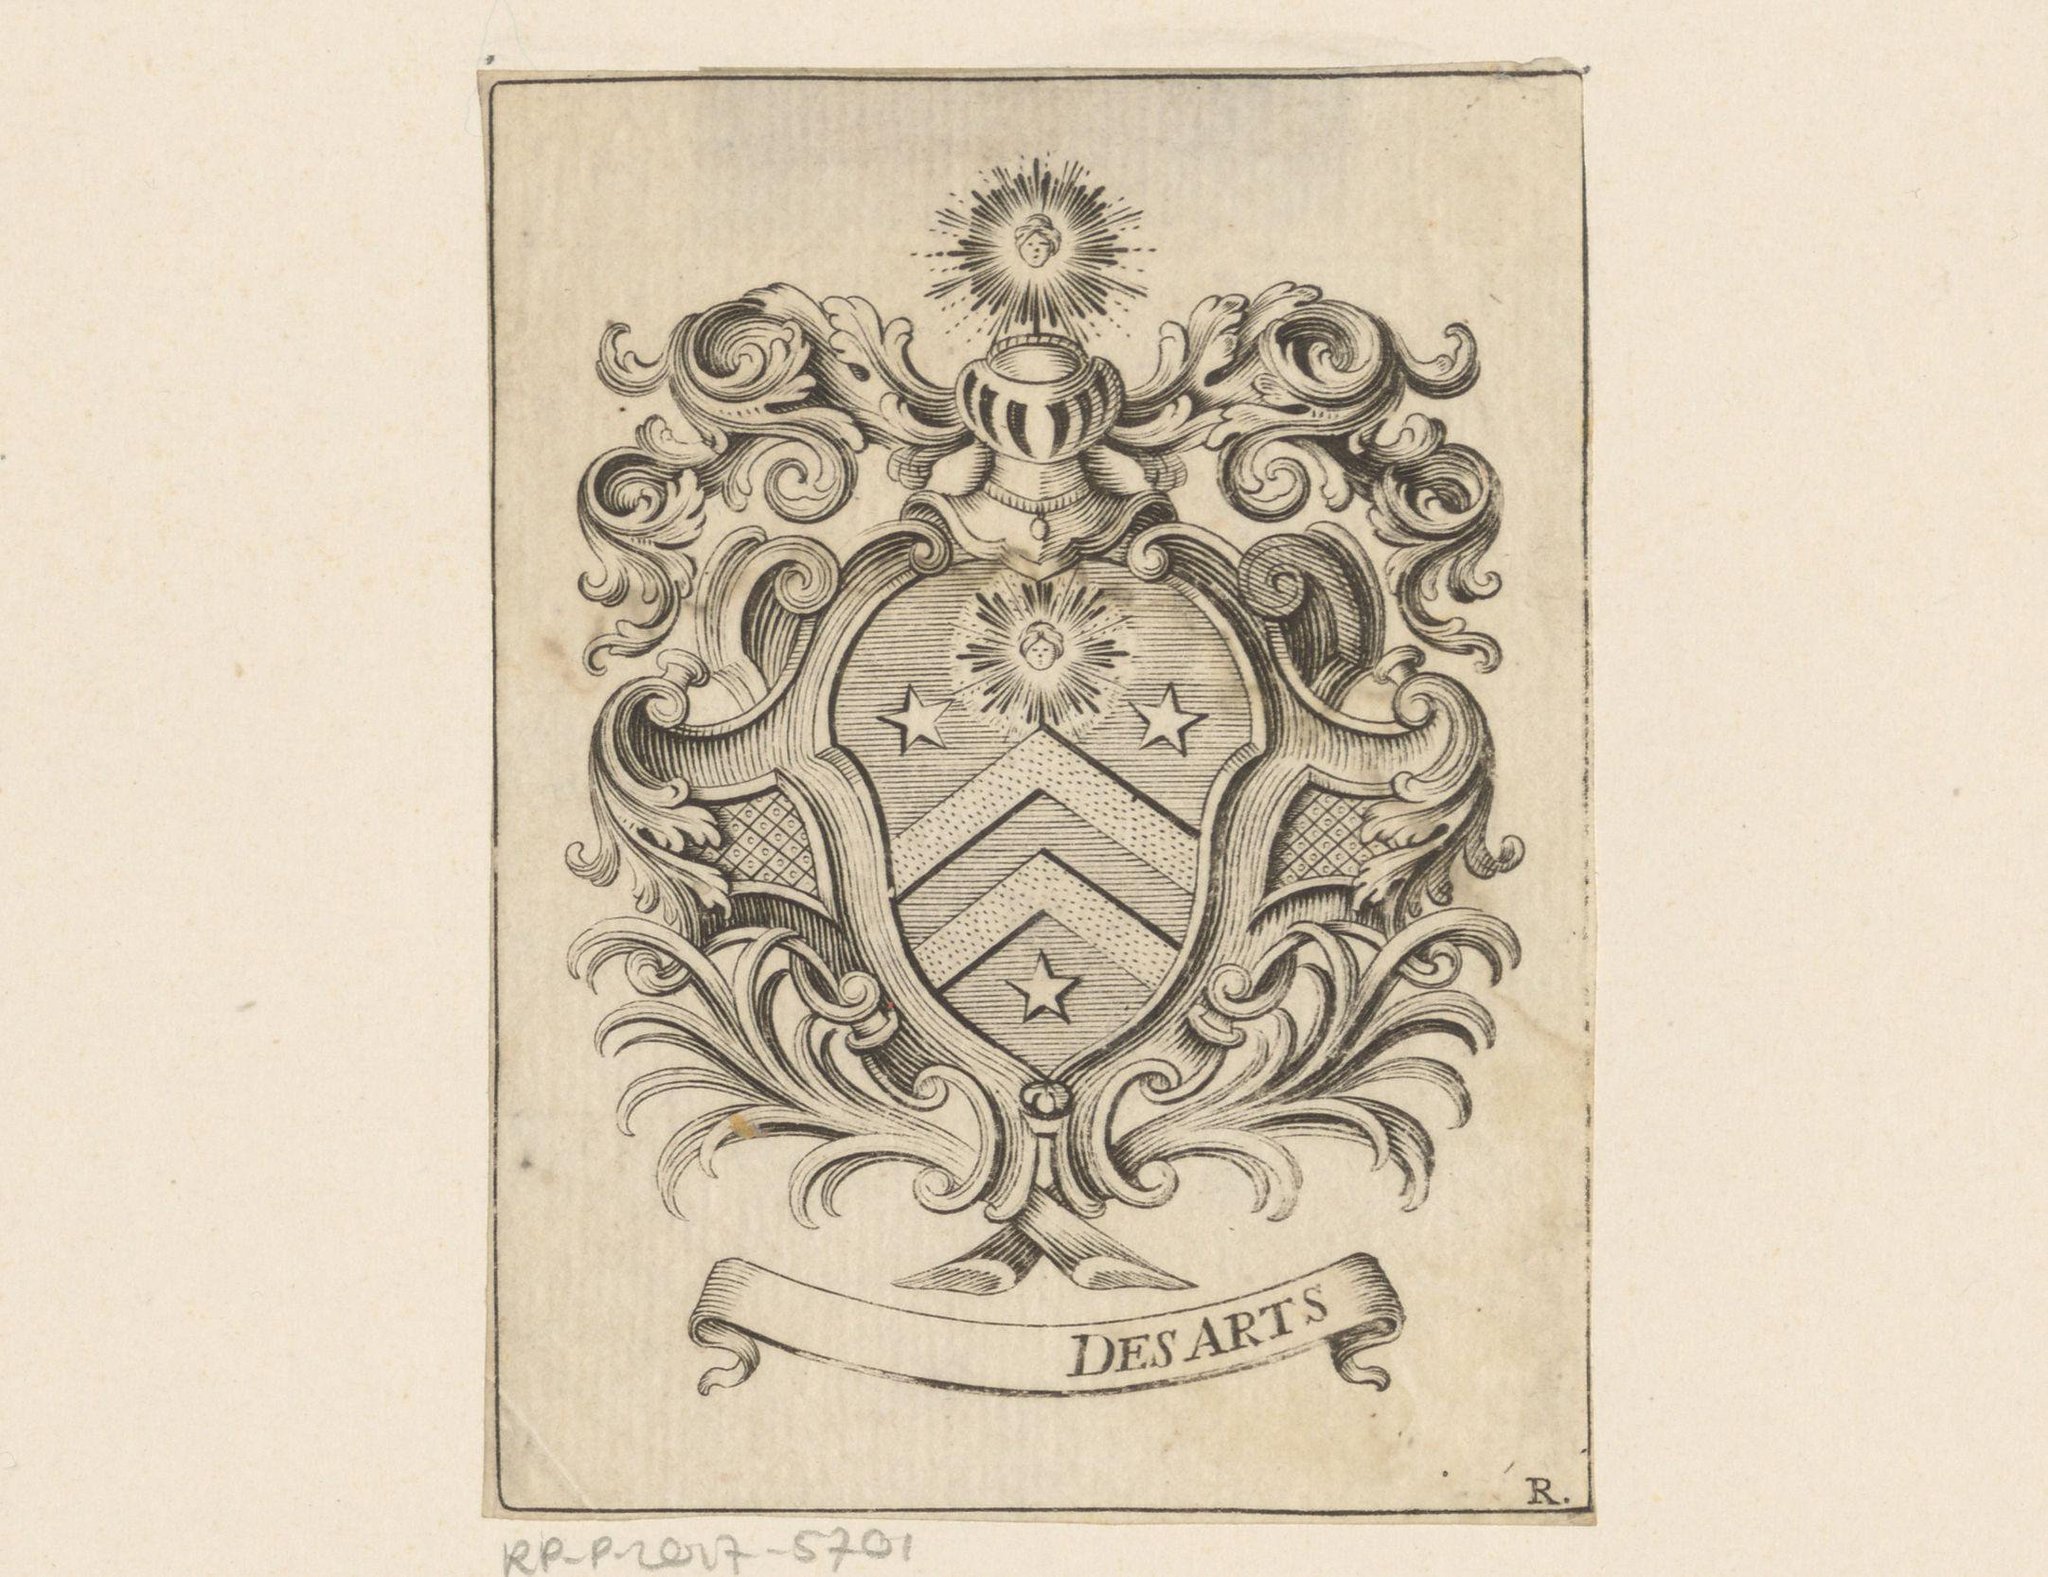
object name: bookplate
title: Ex libris van Desarts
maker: Anonymous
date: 1700-1799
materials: paper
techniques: etching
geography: france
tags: armorial bearing, heraldry